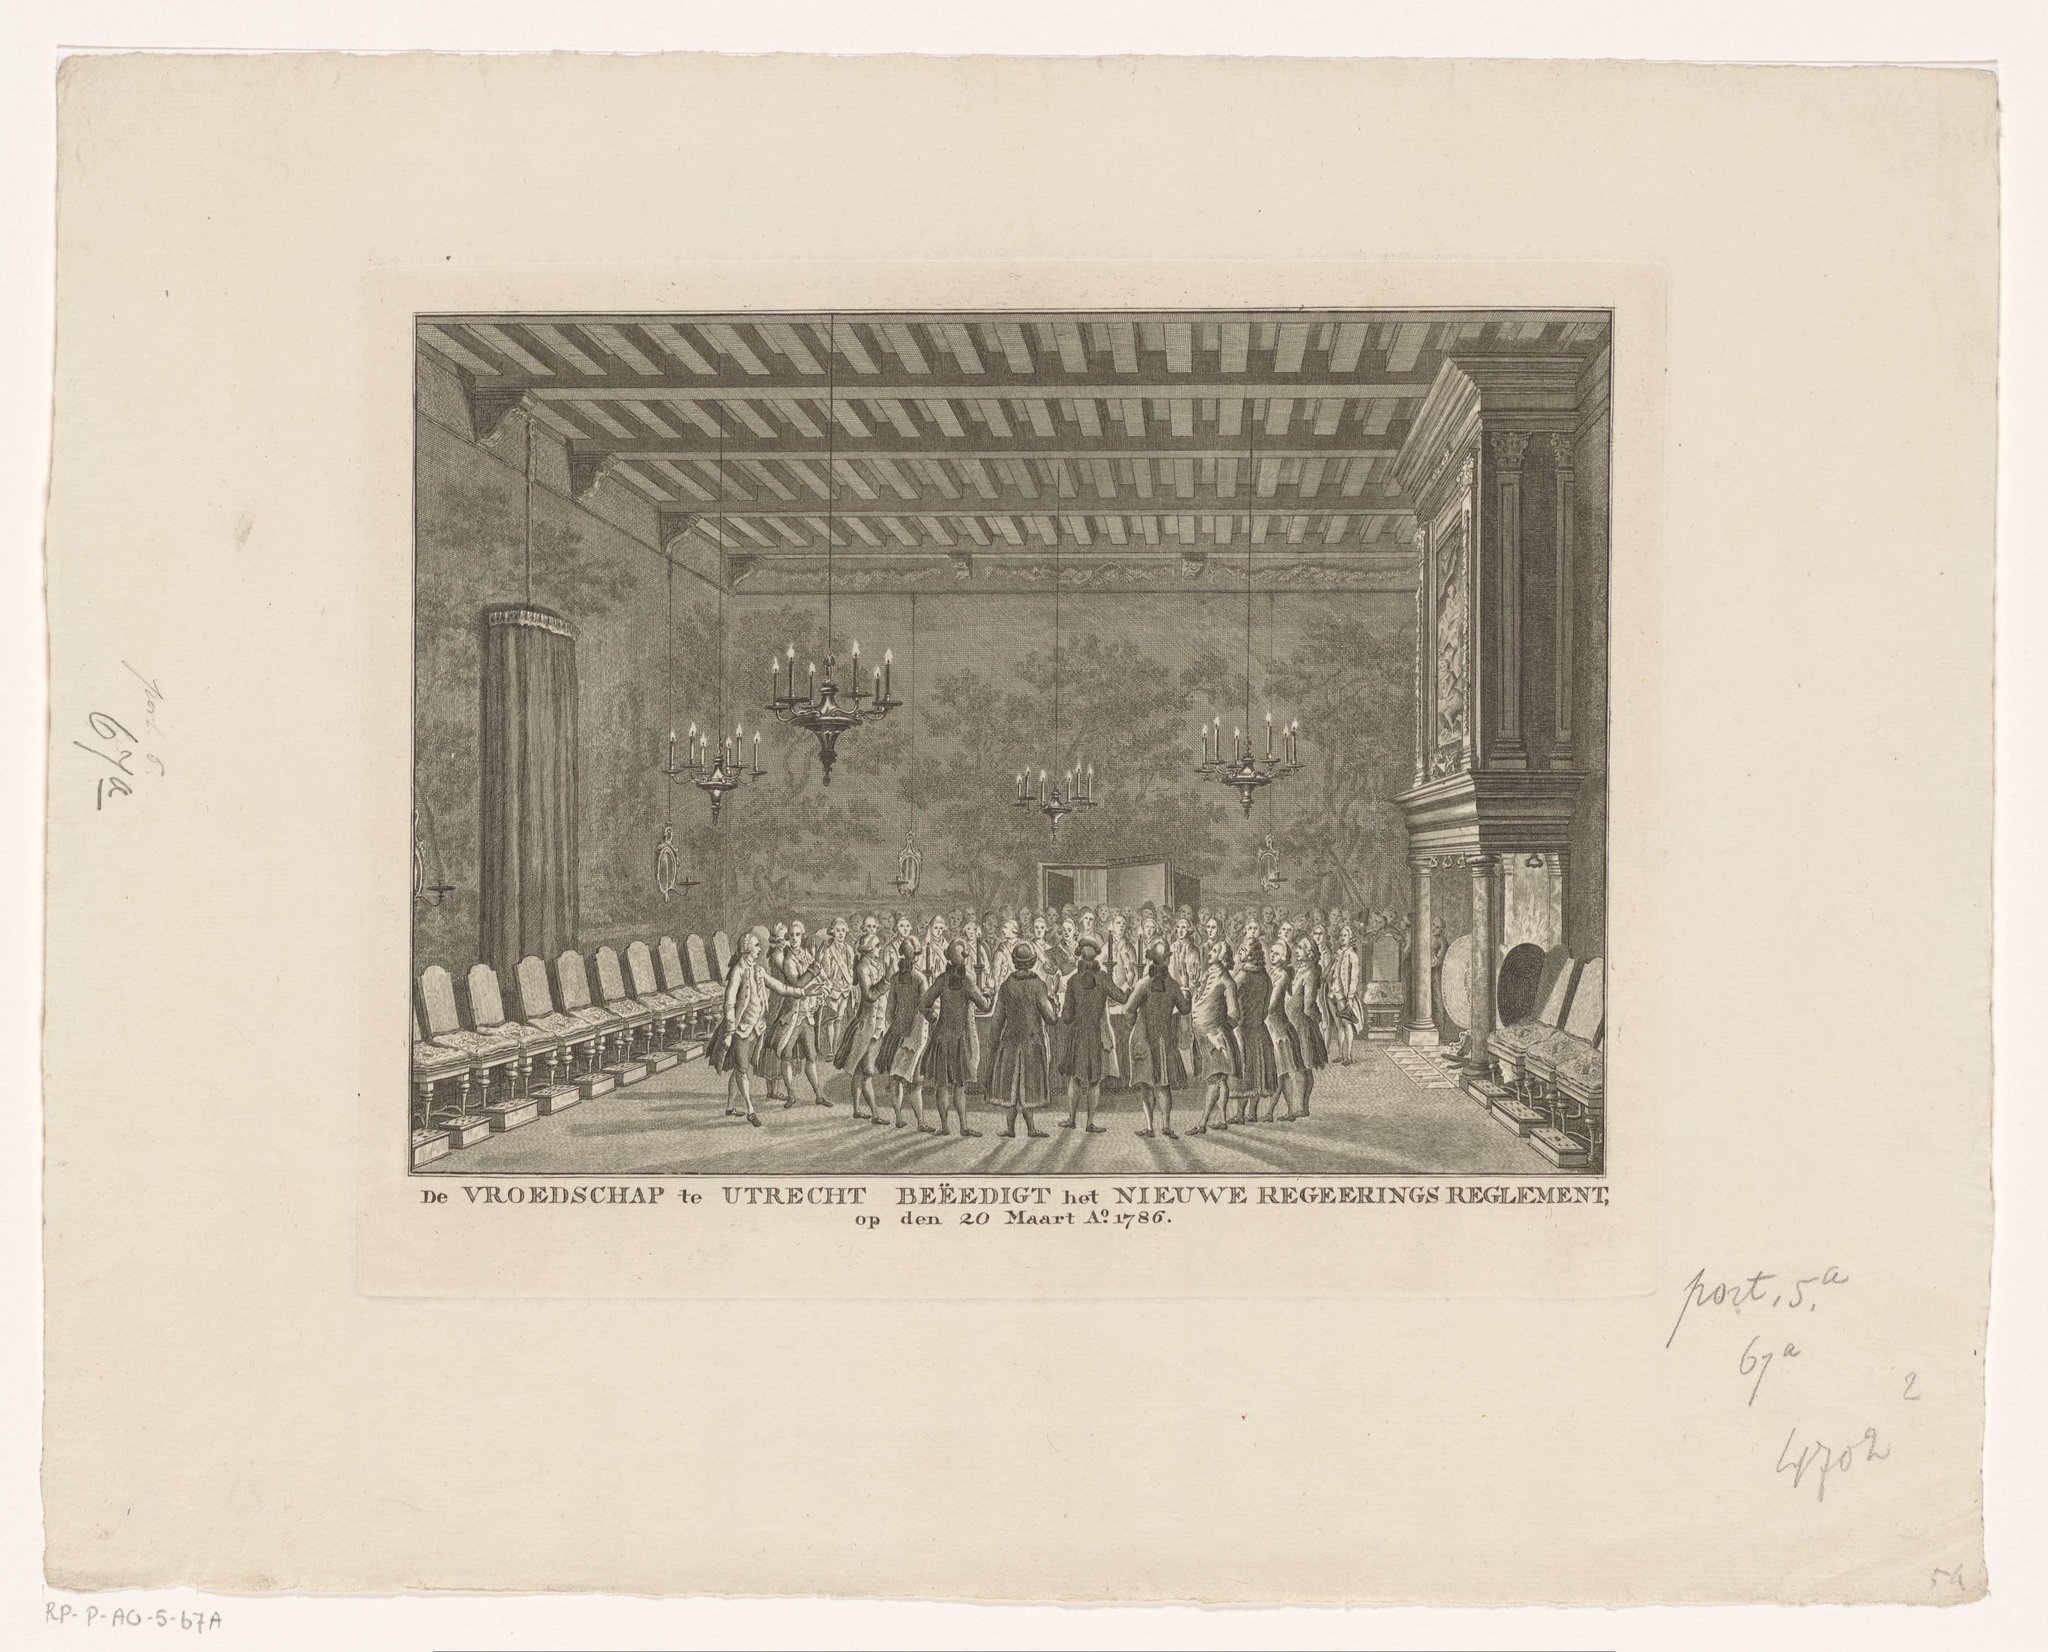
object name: print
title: De vroedschap te Utrecht beëdigt het nieuwe regeerings reglement, op den 20 Maart Ao. 1786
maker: carel frederik bendorp (i)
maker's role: print maker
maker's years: 1736-1814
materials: paper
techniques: engraving, etching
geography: northern netherlands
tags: city council, swearing an oath (with two fingers raised), patriots (1780-1795)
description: De leden van de vroedschap van Utrecht leggen de eed af op het nieuwe regeringsreglement, in het stadhuis van Utrecht, 20 maart 1786. Interieur met de leden opgesteld in een kring rond een tafel.